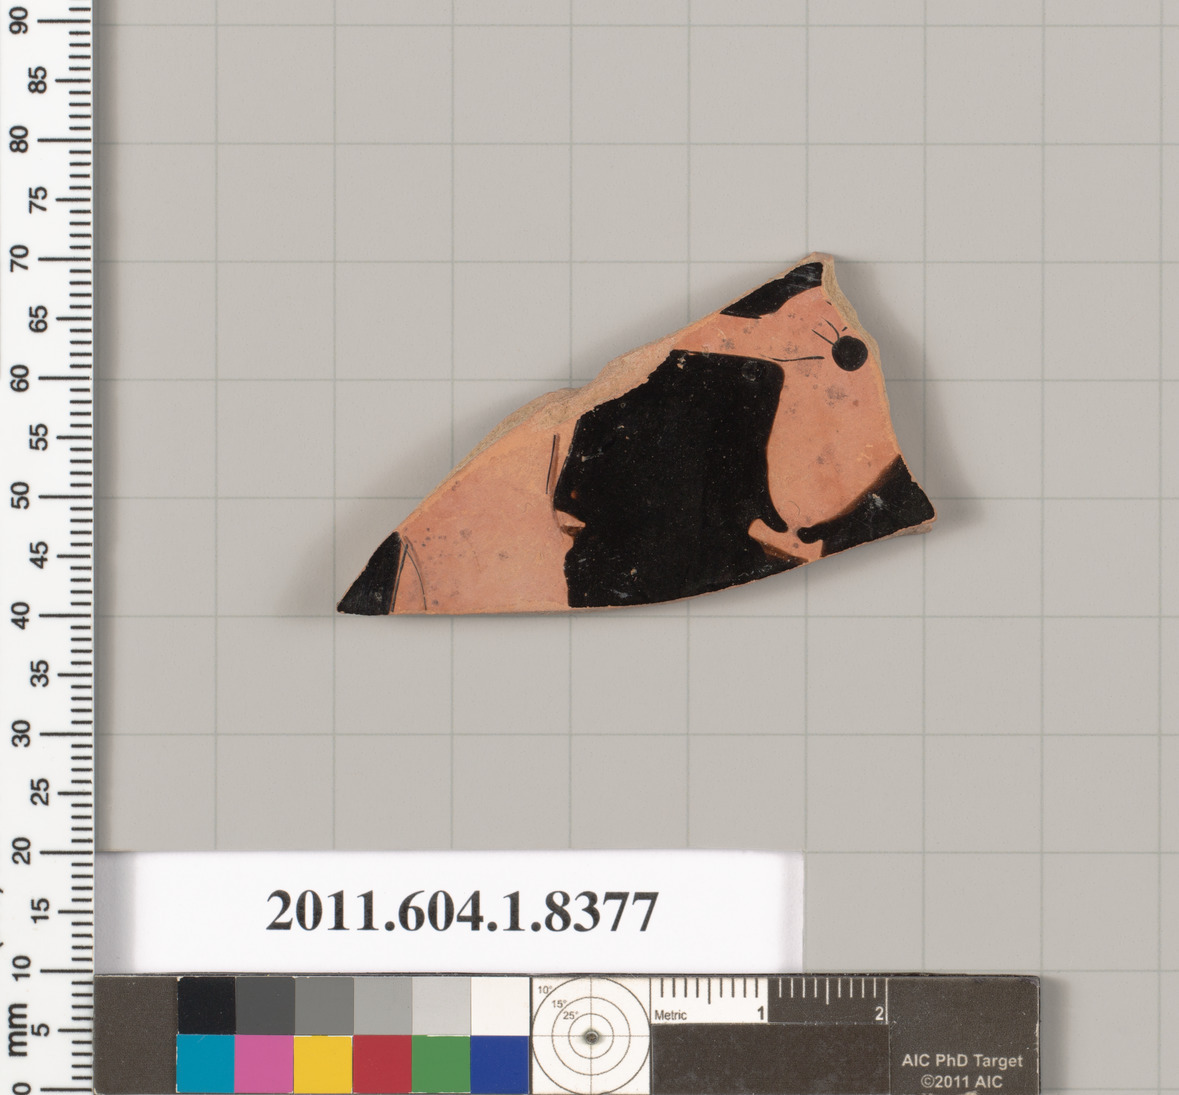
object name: kylix fragment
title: Terracotta fragment of a kylix (drinking cup)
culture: greek, attic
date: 400-351 BCE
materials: terracotta